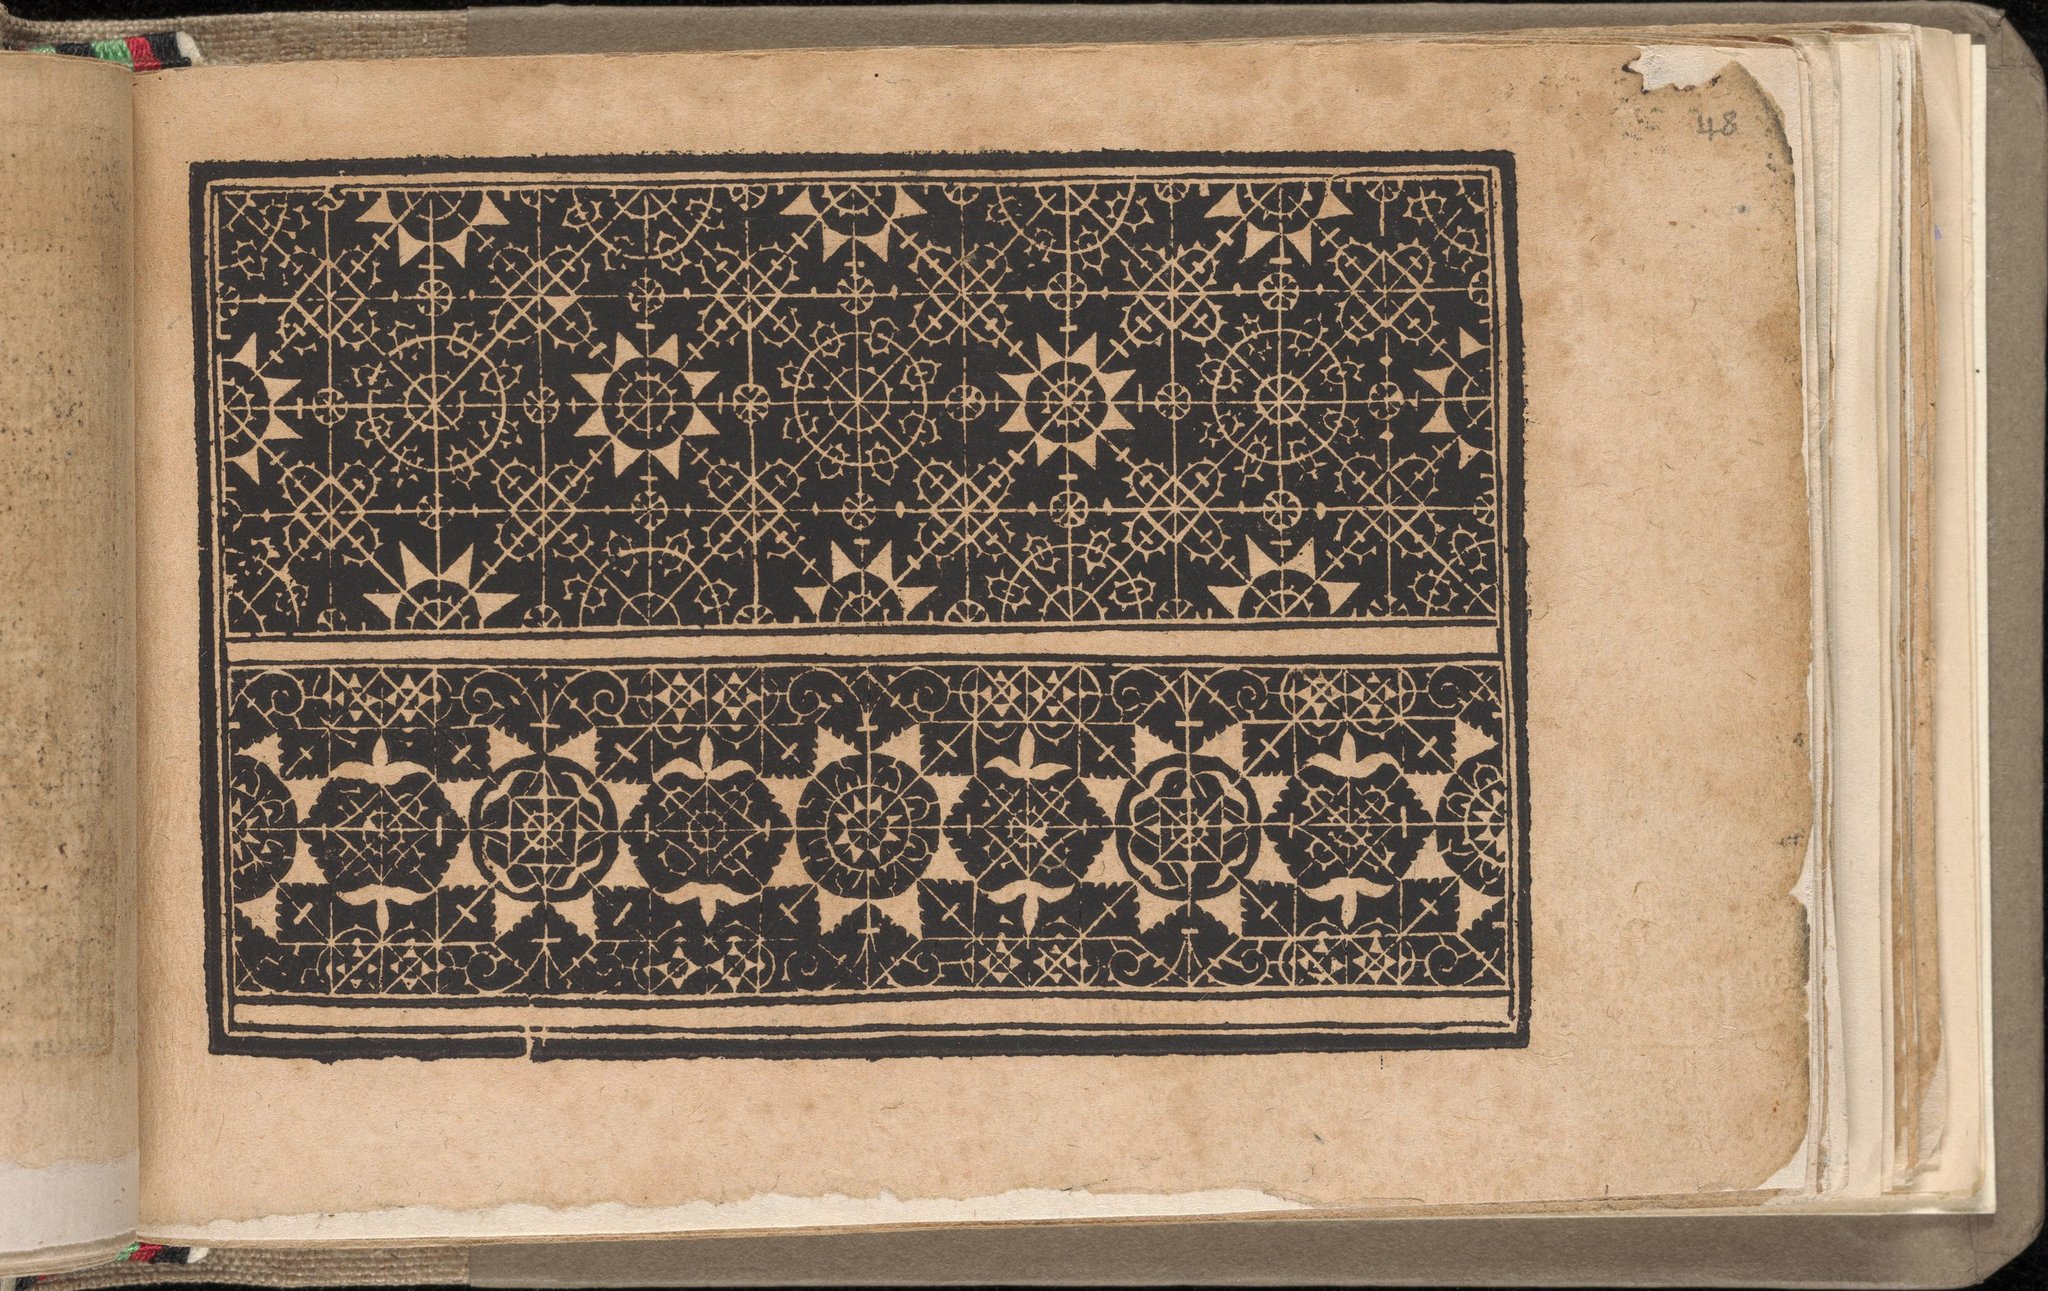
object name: book print ornament architecture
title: Schön newes Modelbuch (Page 48r)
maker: sigismundus latomus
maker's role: publisher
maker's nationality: german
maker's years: 1599-1632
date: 1608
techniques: woodcut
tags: ornament